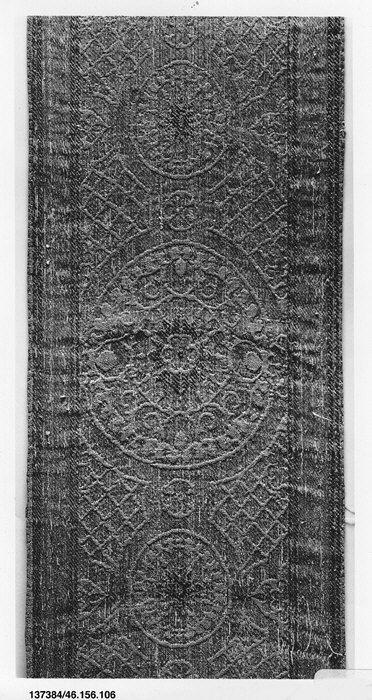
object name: orphrey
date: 1451-1500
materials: linen, metal thread, silk